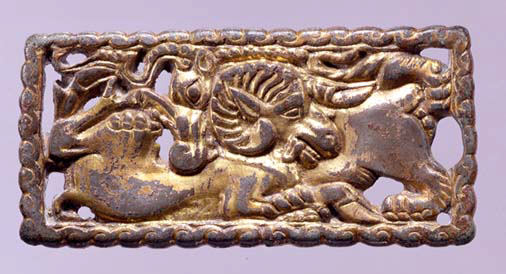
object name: belt buckle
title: Belt Buckle with Wolf and Ram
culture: north chinese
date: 300-101 BCE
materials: bronze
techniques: gilding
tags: animals,rams